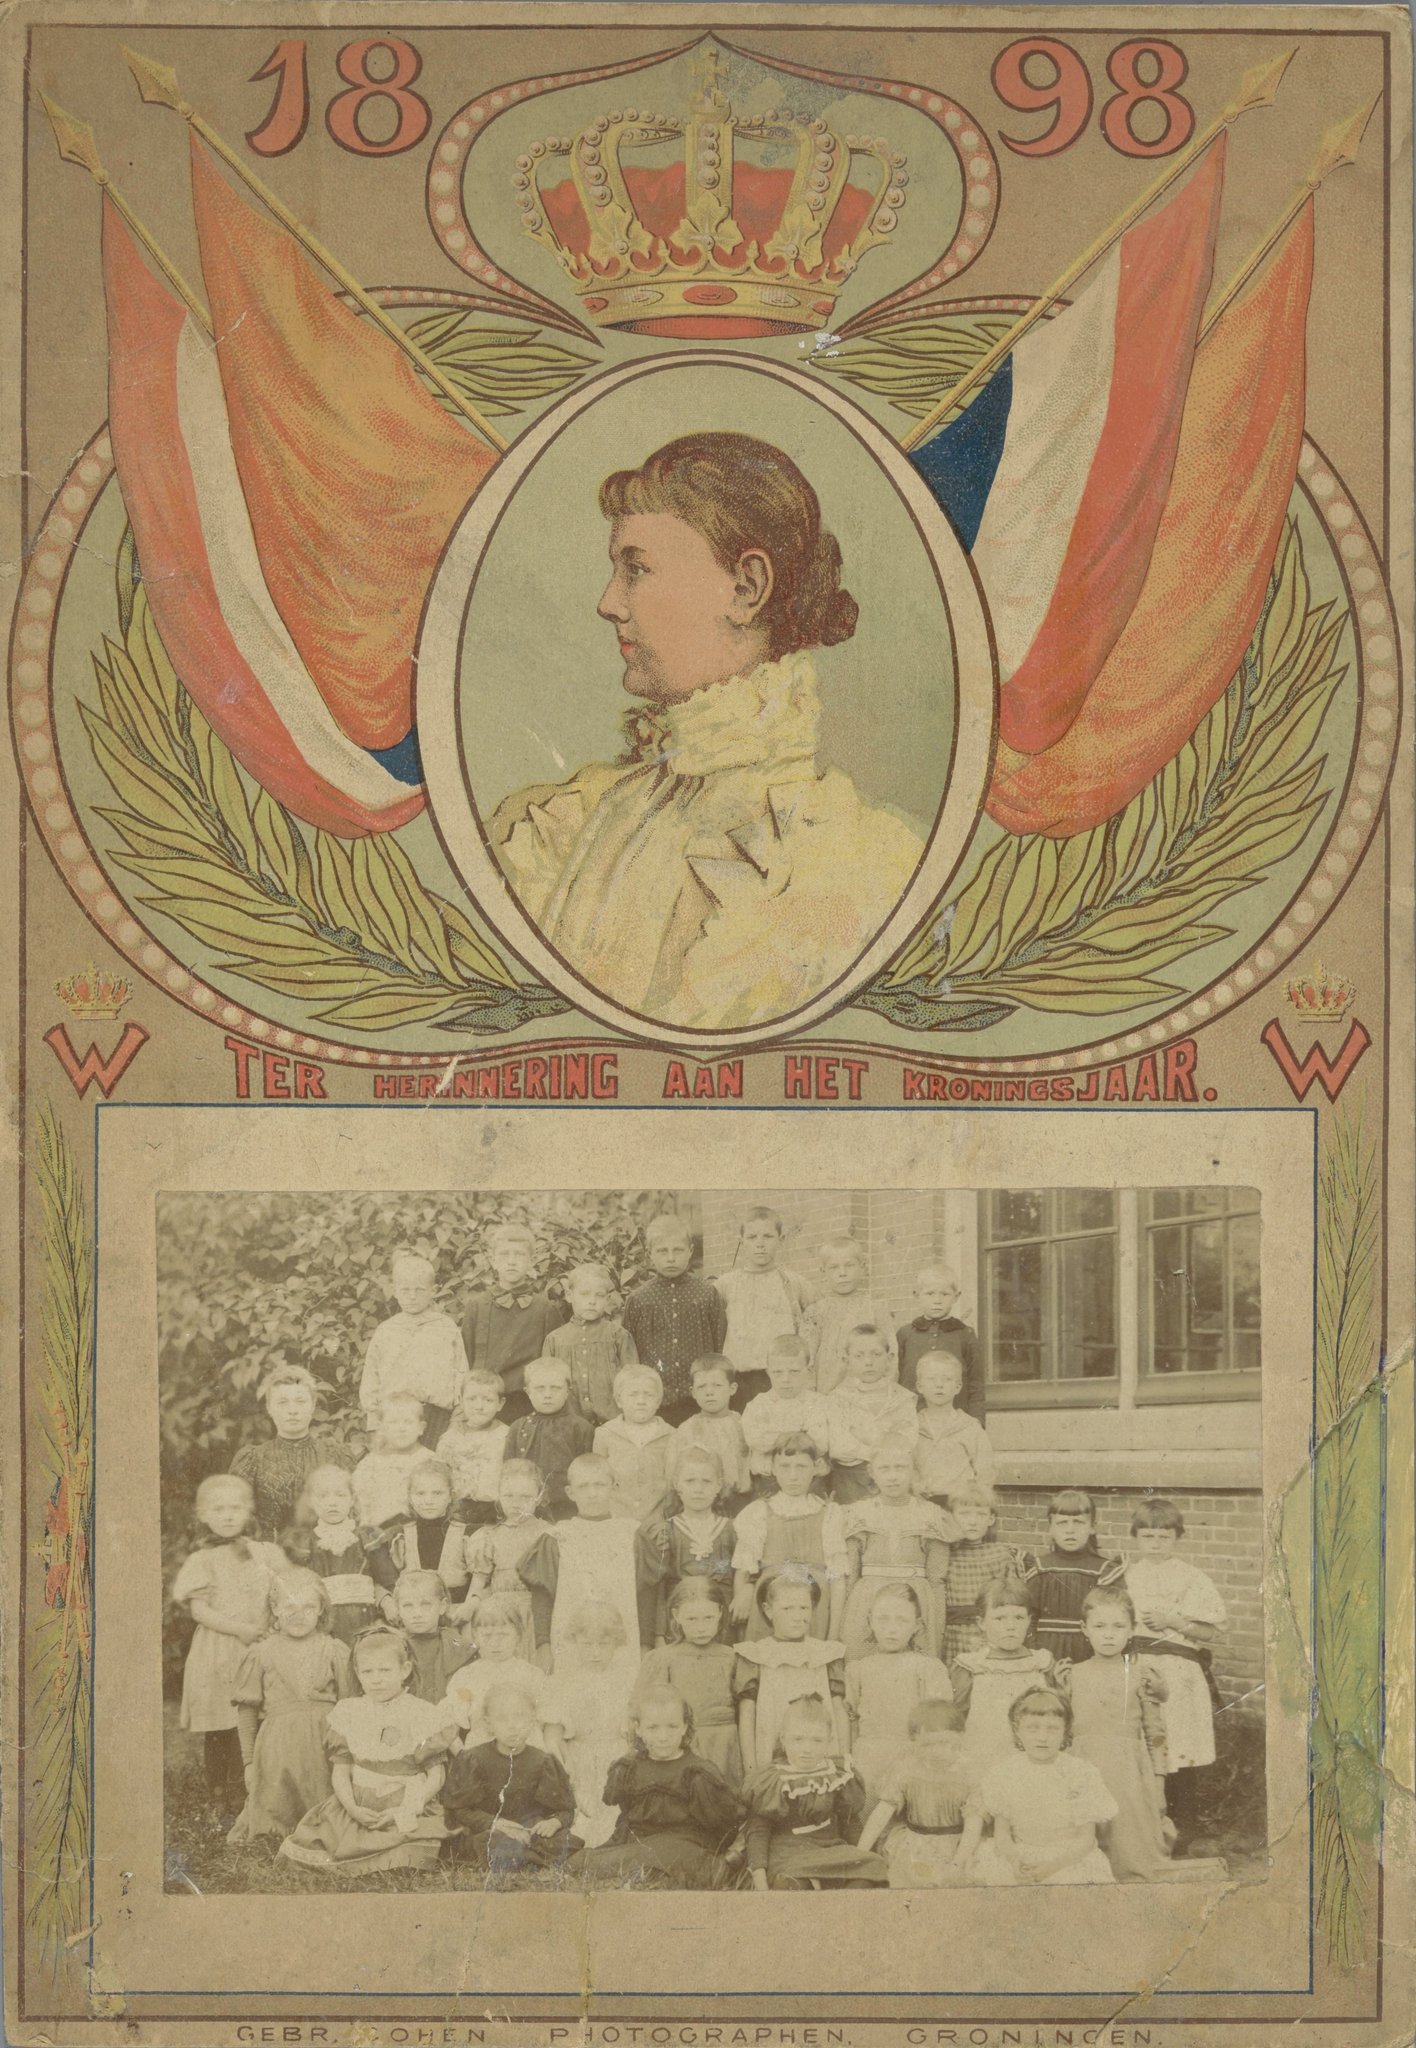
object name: photograph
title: Schoolfoto uit het kroningsjaar 1898 op passepartout met een afbeelding van koningin Wilhelmina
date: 1898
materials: cardboard, photographic support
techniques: albumen print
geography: groningen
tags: the hague, print maker, wilhelmina of the netherlands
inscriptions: inscription: ‘GEBR. COHEN PHOTOGRAPHEN, GRONINGEN.’, inscription: ‘18 / 98 / W / Ter herinnering aan het kroningsjaar. / W’